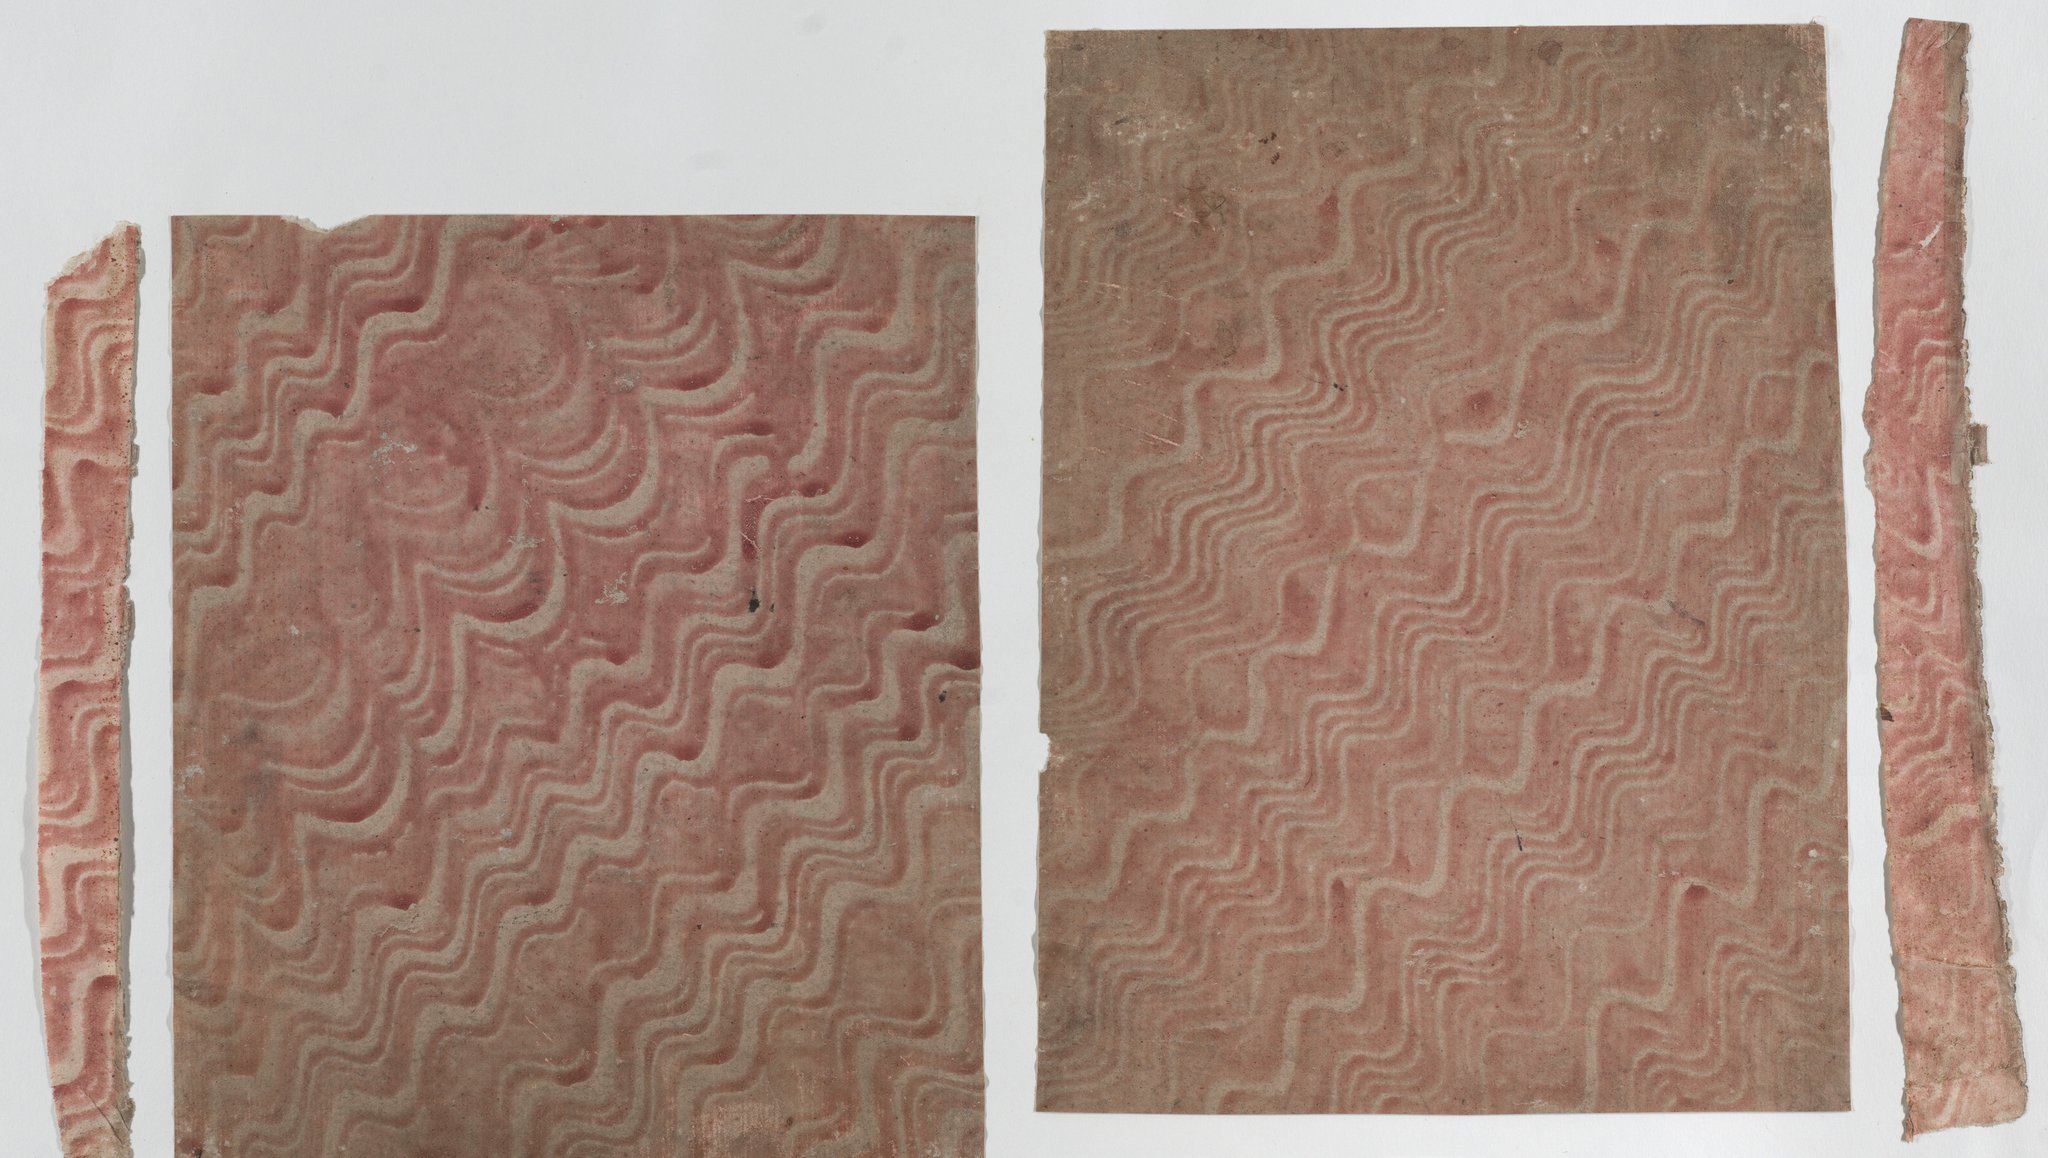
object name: book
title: (Manufacturer's Catalogue of furniture mounts, candelabra, etc.)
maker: anonymous, british, 18th century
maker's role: artist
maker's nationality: british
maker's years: 1700-1800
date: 1701-1800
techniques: engraving, etching